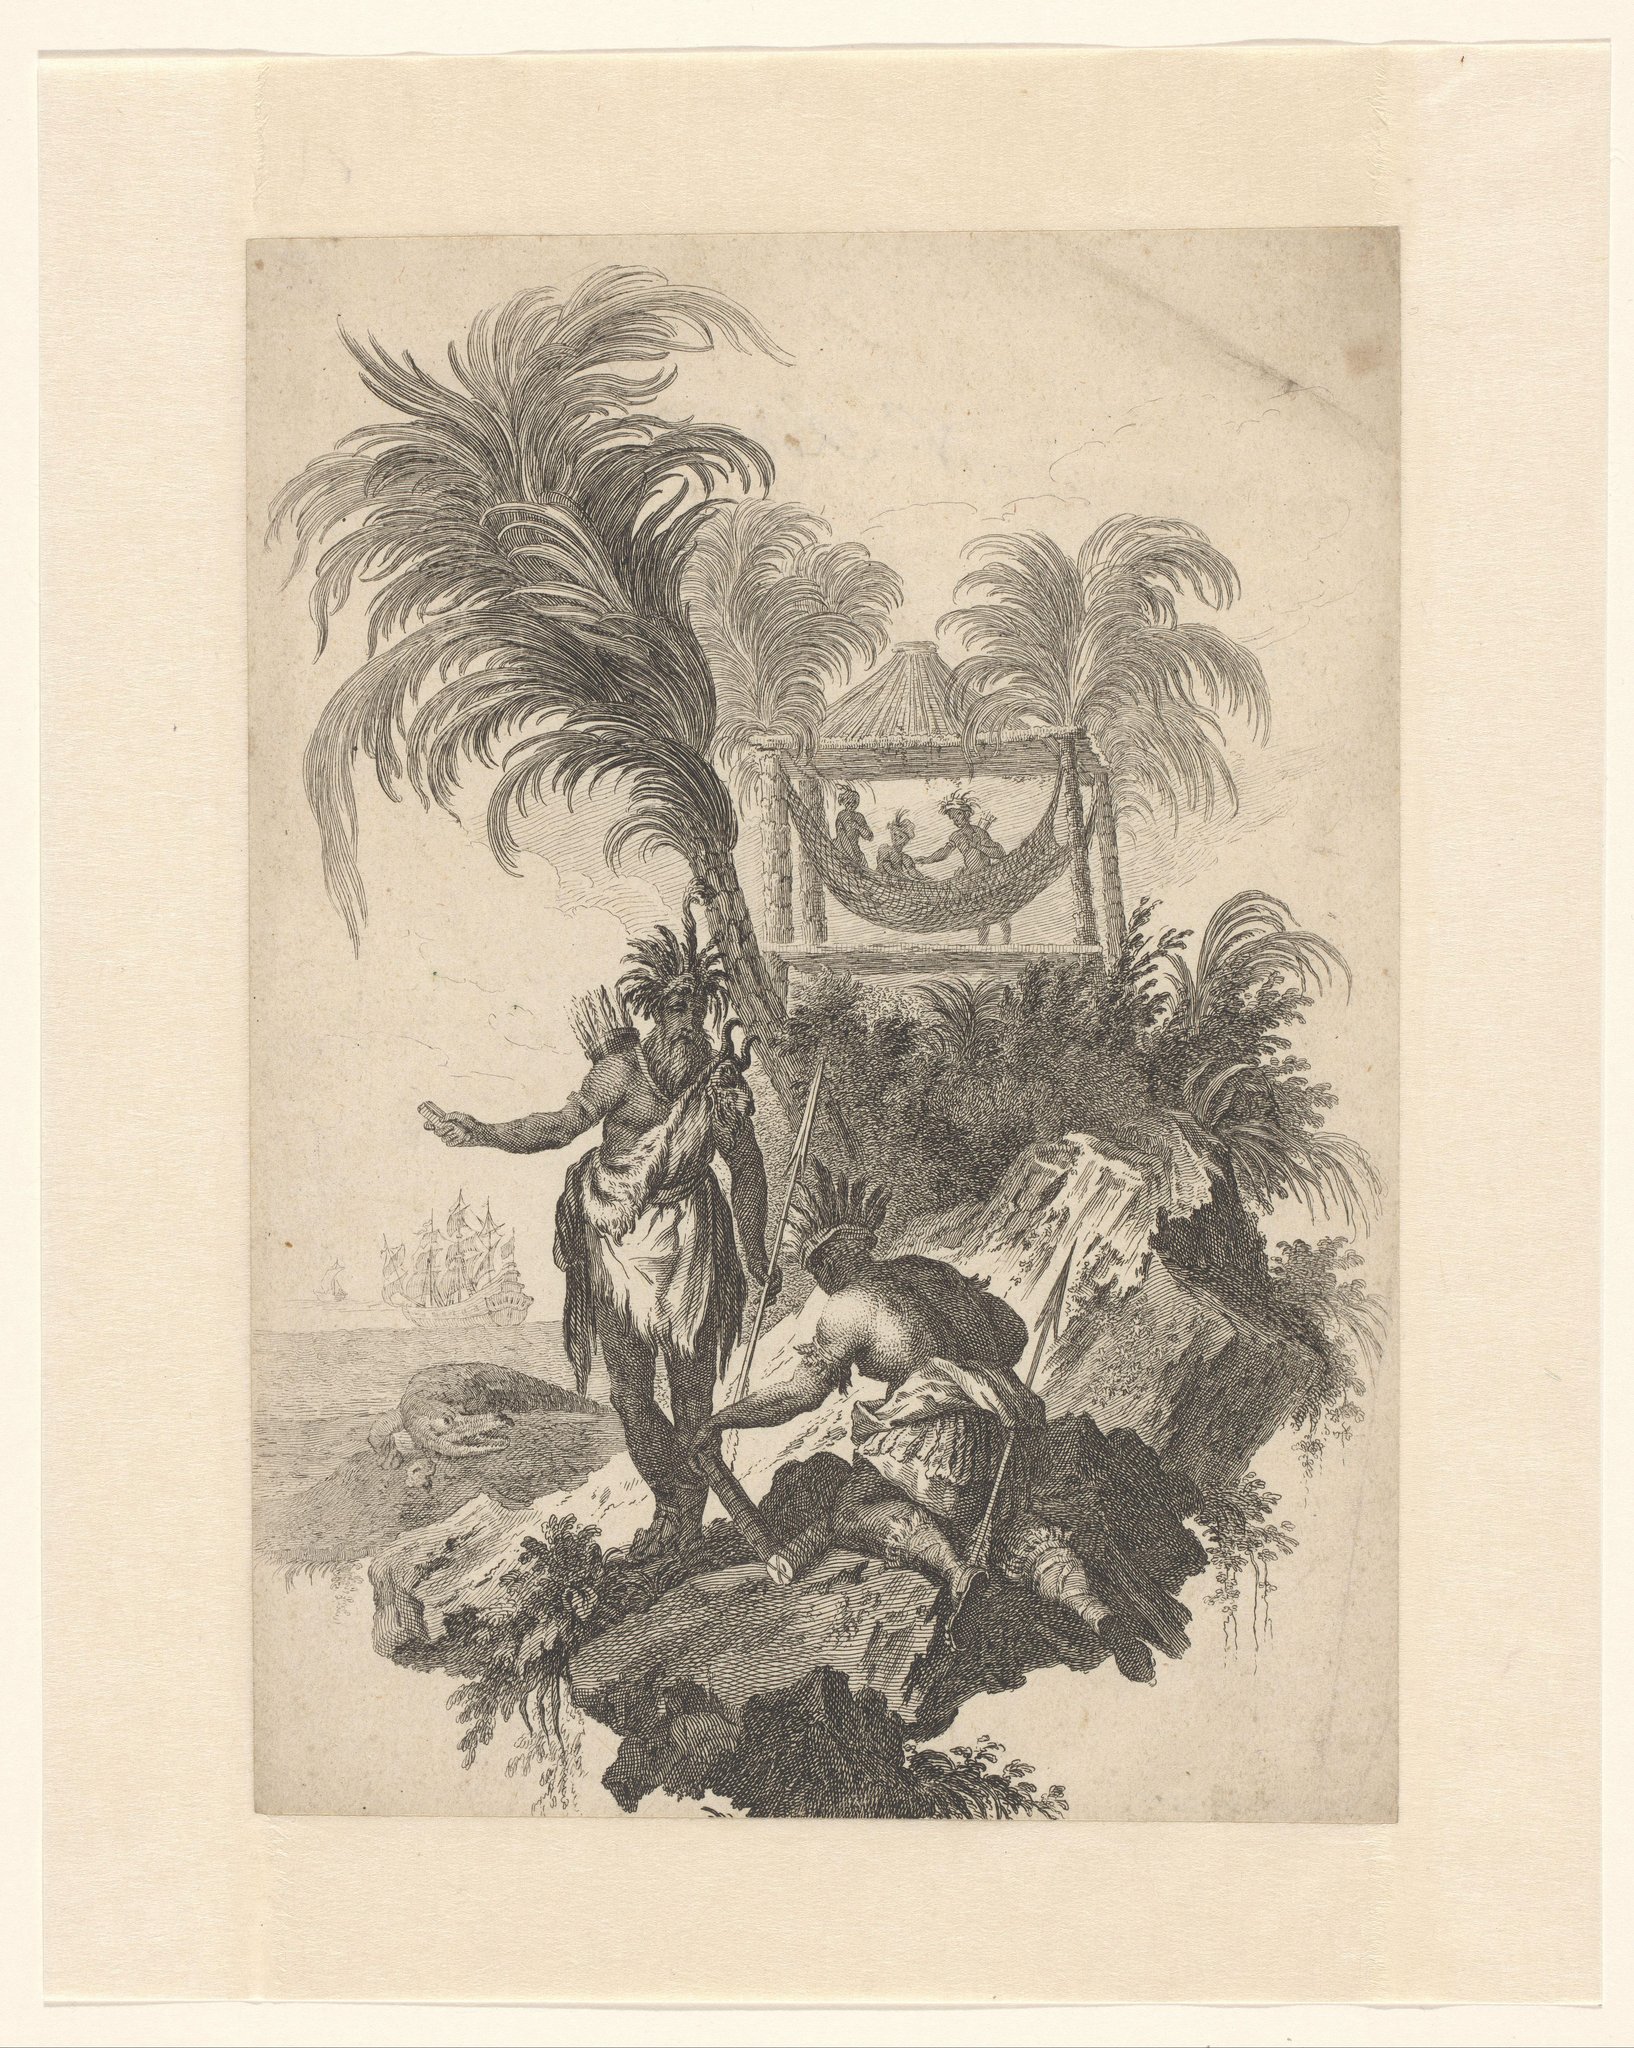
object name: print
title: Man en vrouw met verentooi in landschap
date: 1750-1799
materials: paper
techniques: etching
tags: landscapes (+ landscape with figures, staffage)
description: Een man met verentooi, pijlenkoker, lendendoek en geitenvel staat in een landschap met palmbomen. Voor hem knielt een vrouw met verentooi en verenrok. Achter hen staan die figuren met verentooi bij een hangmat onder een afdak tussen vier palmbomen. Links en de achtergrond ligt een krokodil langs het water en varen schepen.